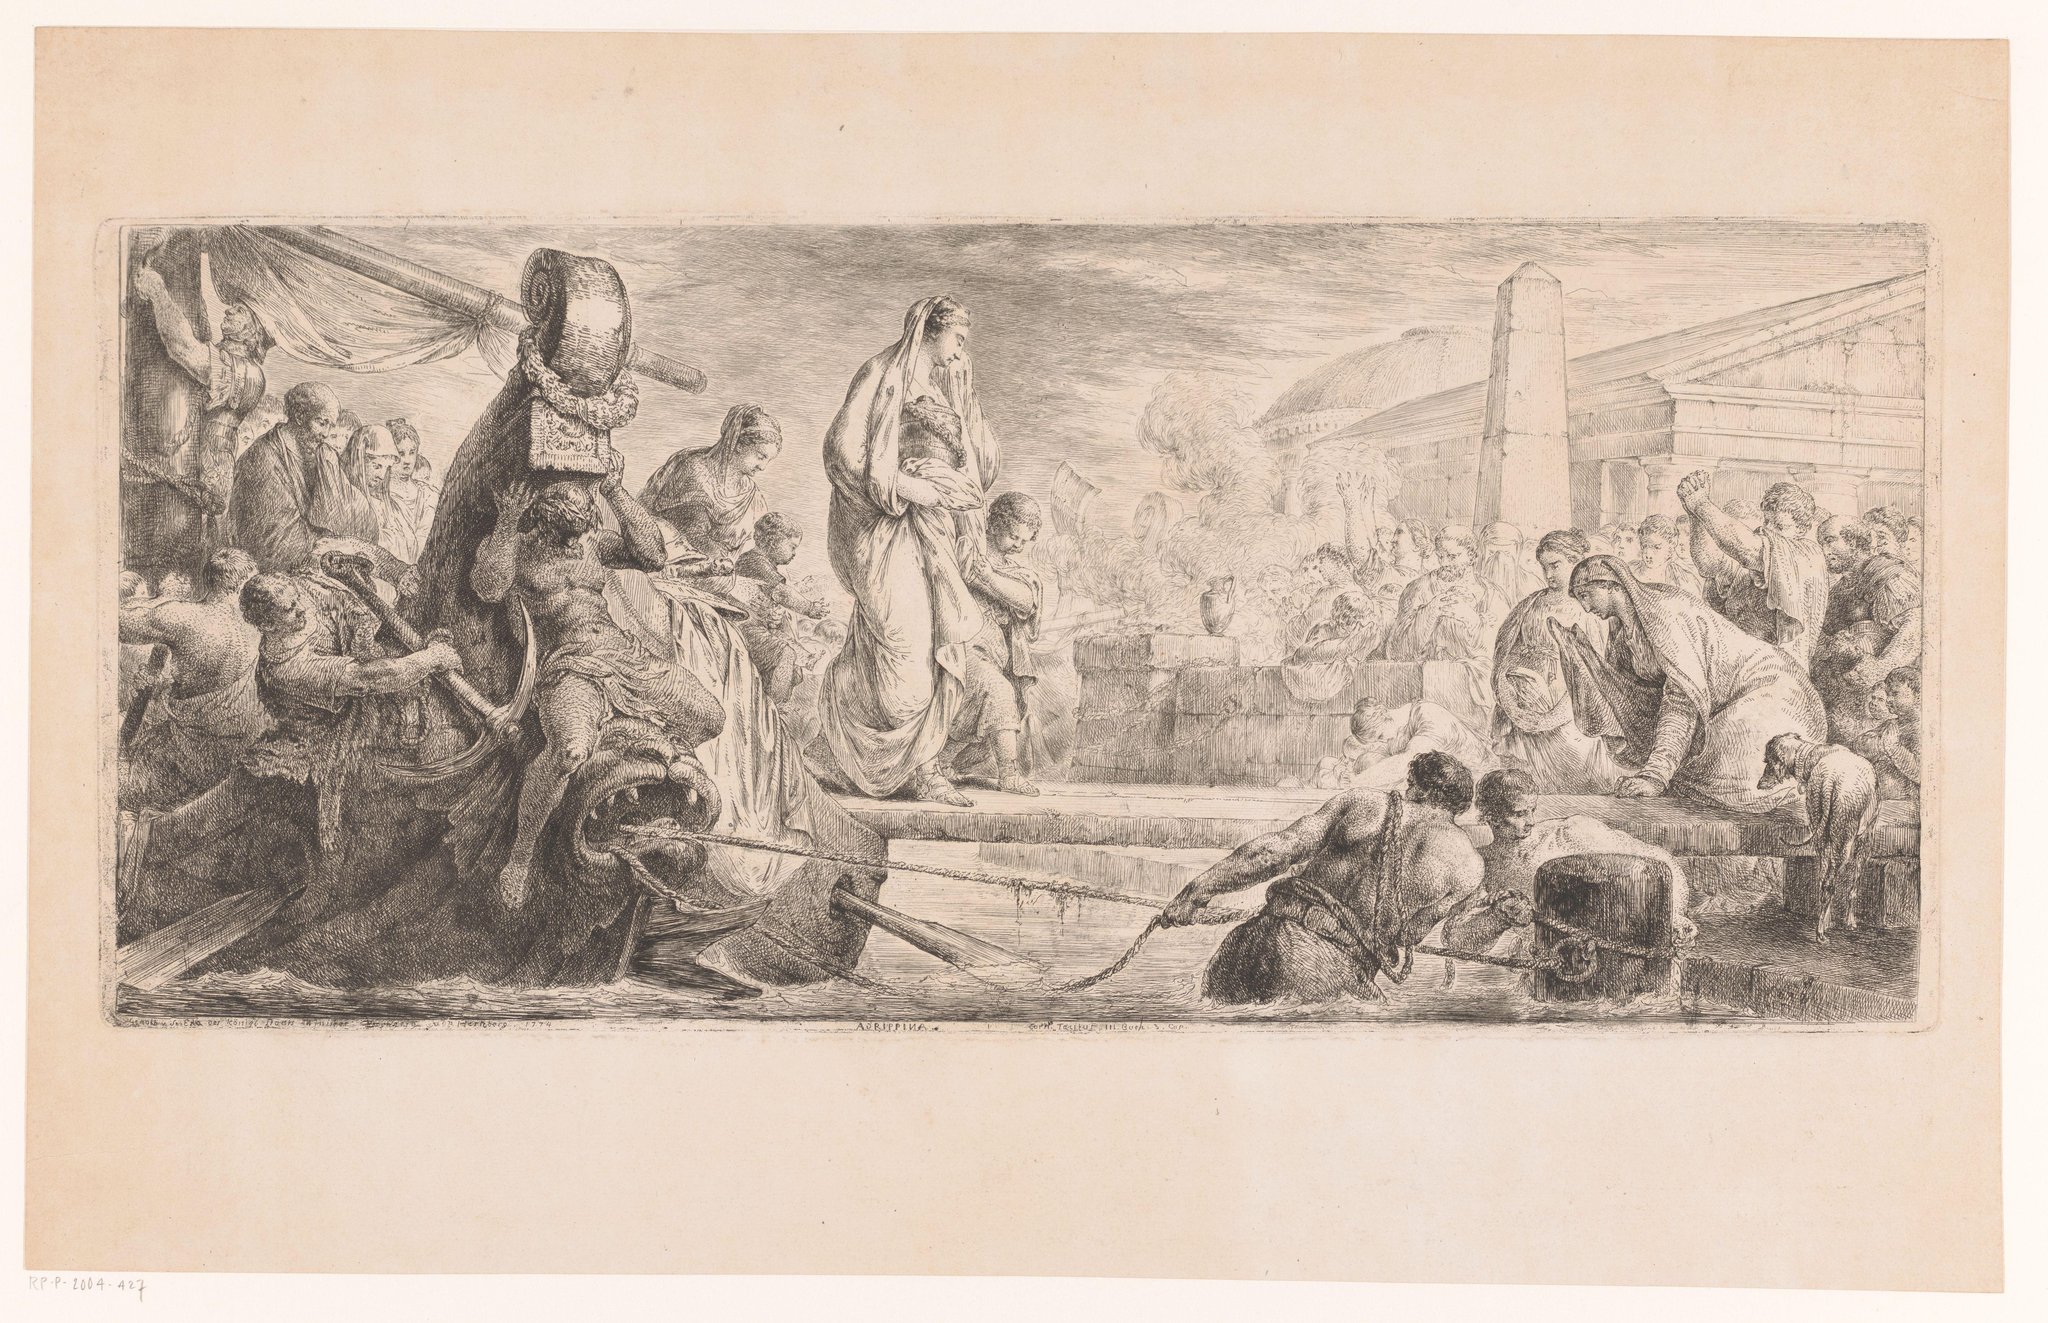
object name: print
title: Agrippina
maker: bernhard rode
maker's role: artist, print maker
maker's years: 1725-1797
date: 1774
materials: paper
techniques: etching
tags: 98c(agrippina the elder)5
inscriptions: collector's mark: Lugt 2228, collector's mark: Lugt 2760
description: Met verwijzing naar Tacitus Annales III.